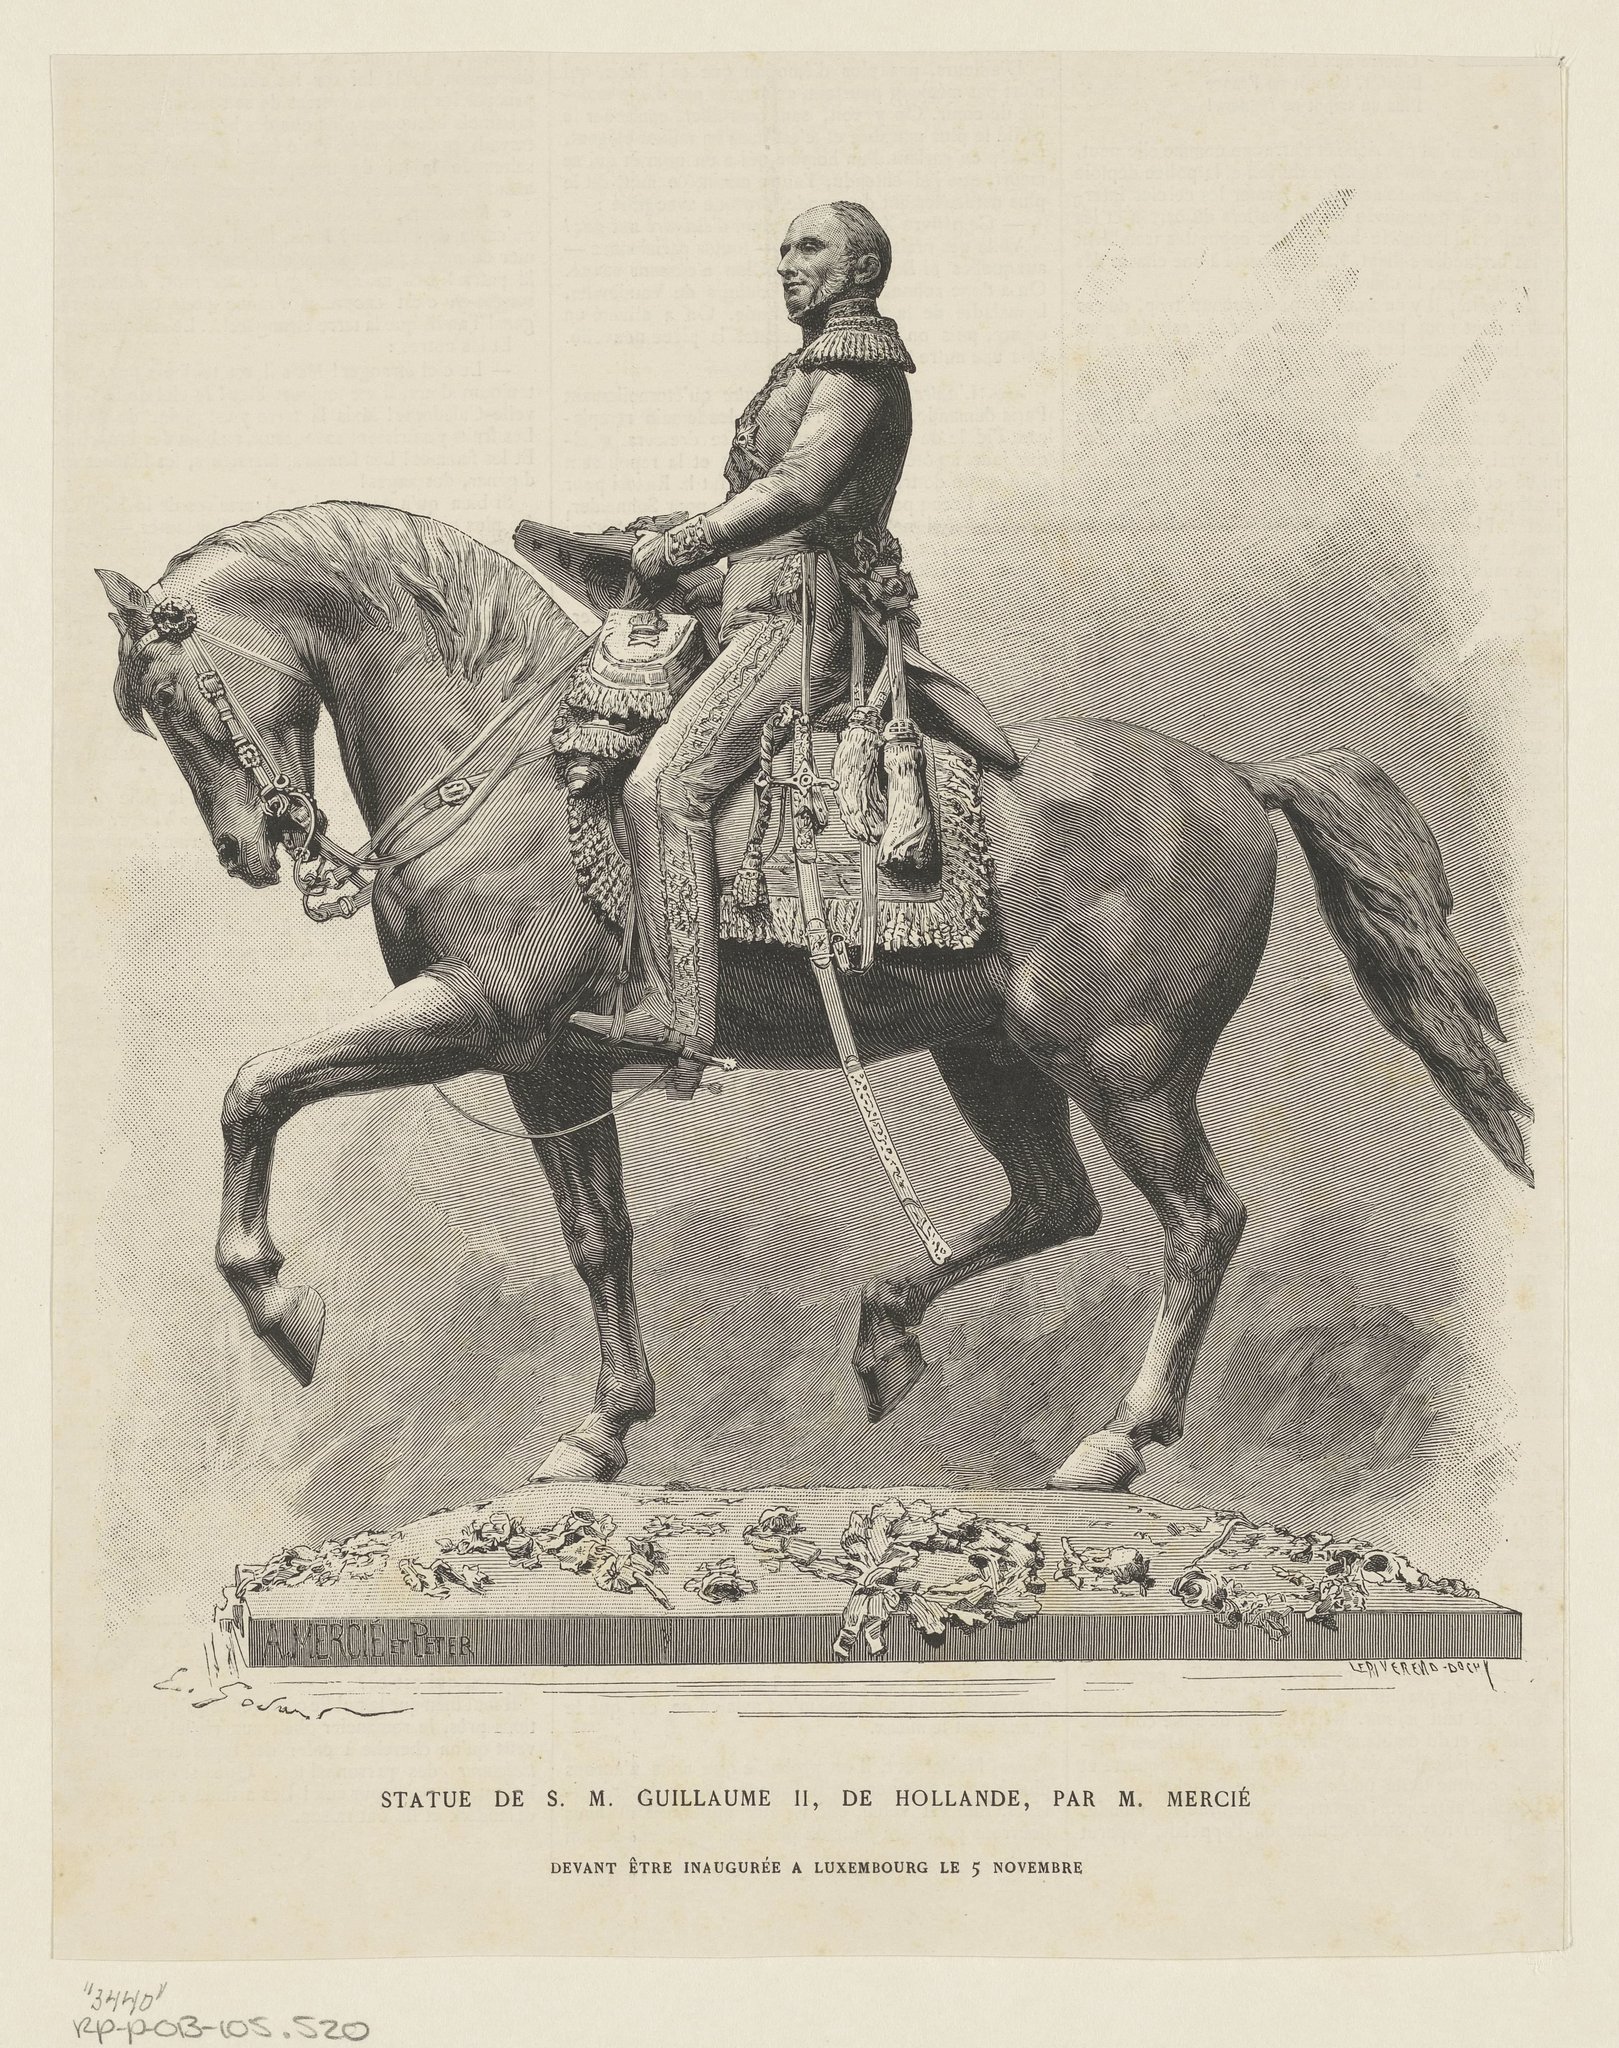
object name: print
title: Ruiterstandbeeld van Willem II, koning der Nederlanden, op het Place Guillaume II te Luxemburg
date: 1884-1949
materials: paper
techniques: letterpress printing, engraving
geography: netherlands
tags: william ii of the netherlands, equestrian statue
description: De hier vermelde titel verwijst naar de hoogst verkregen titel van de geportretteerde, niet per se naar de titel die de geportretteerde op deze voorstelling draagt.